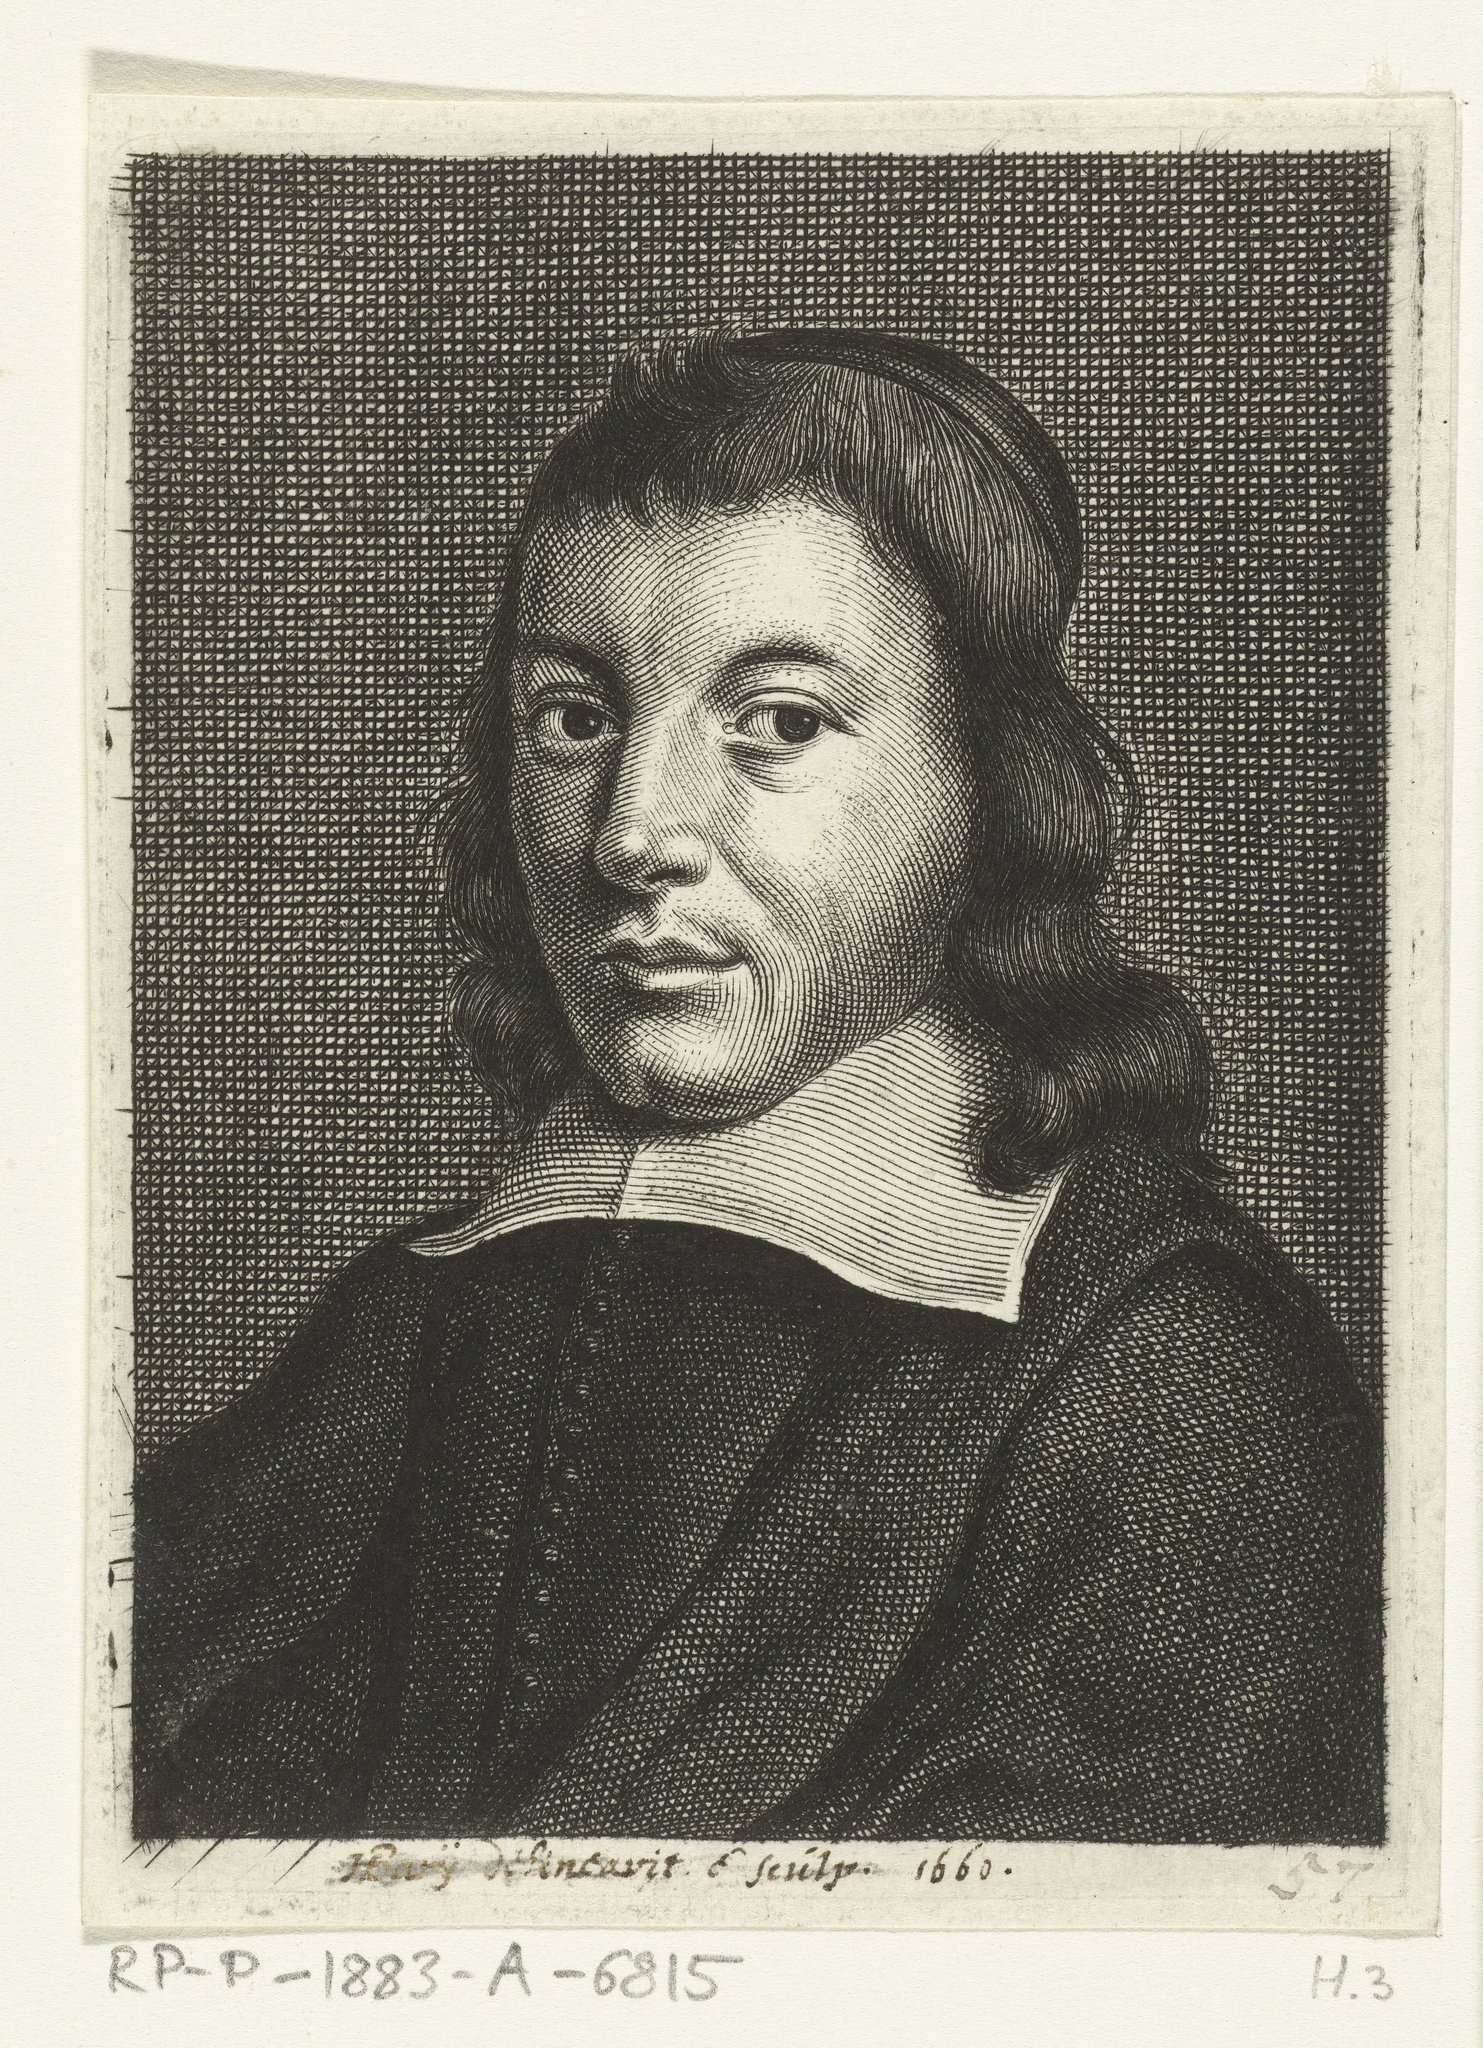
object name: print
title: Zelfportret met kapje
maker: hendrik bary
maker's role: draughtsman, print maker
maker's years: 1640-1707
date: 1660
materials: paper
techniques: engraving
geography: netherlands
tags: gouda, print maker, draughtsman, hendrik bary, portrait, self-portrait of artist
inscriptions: inscription: ‘H. Barij delineavit et sculpsit 1660’, collector's mark: Lugt 2228